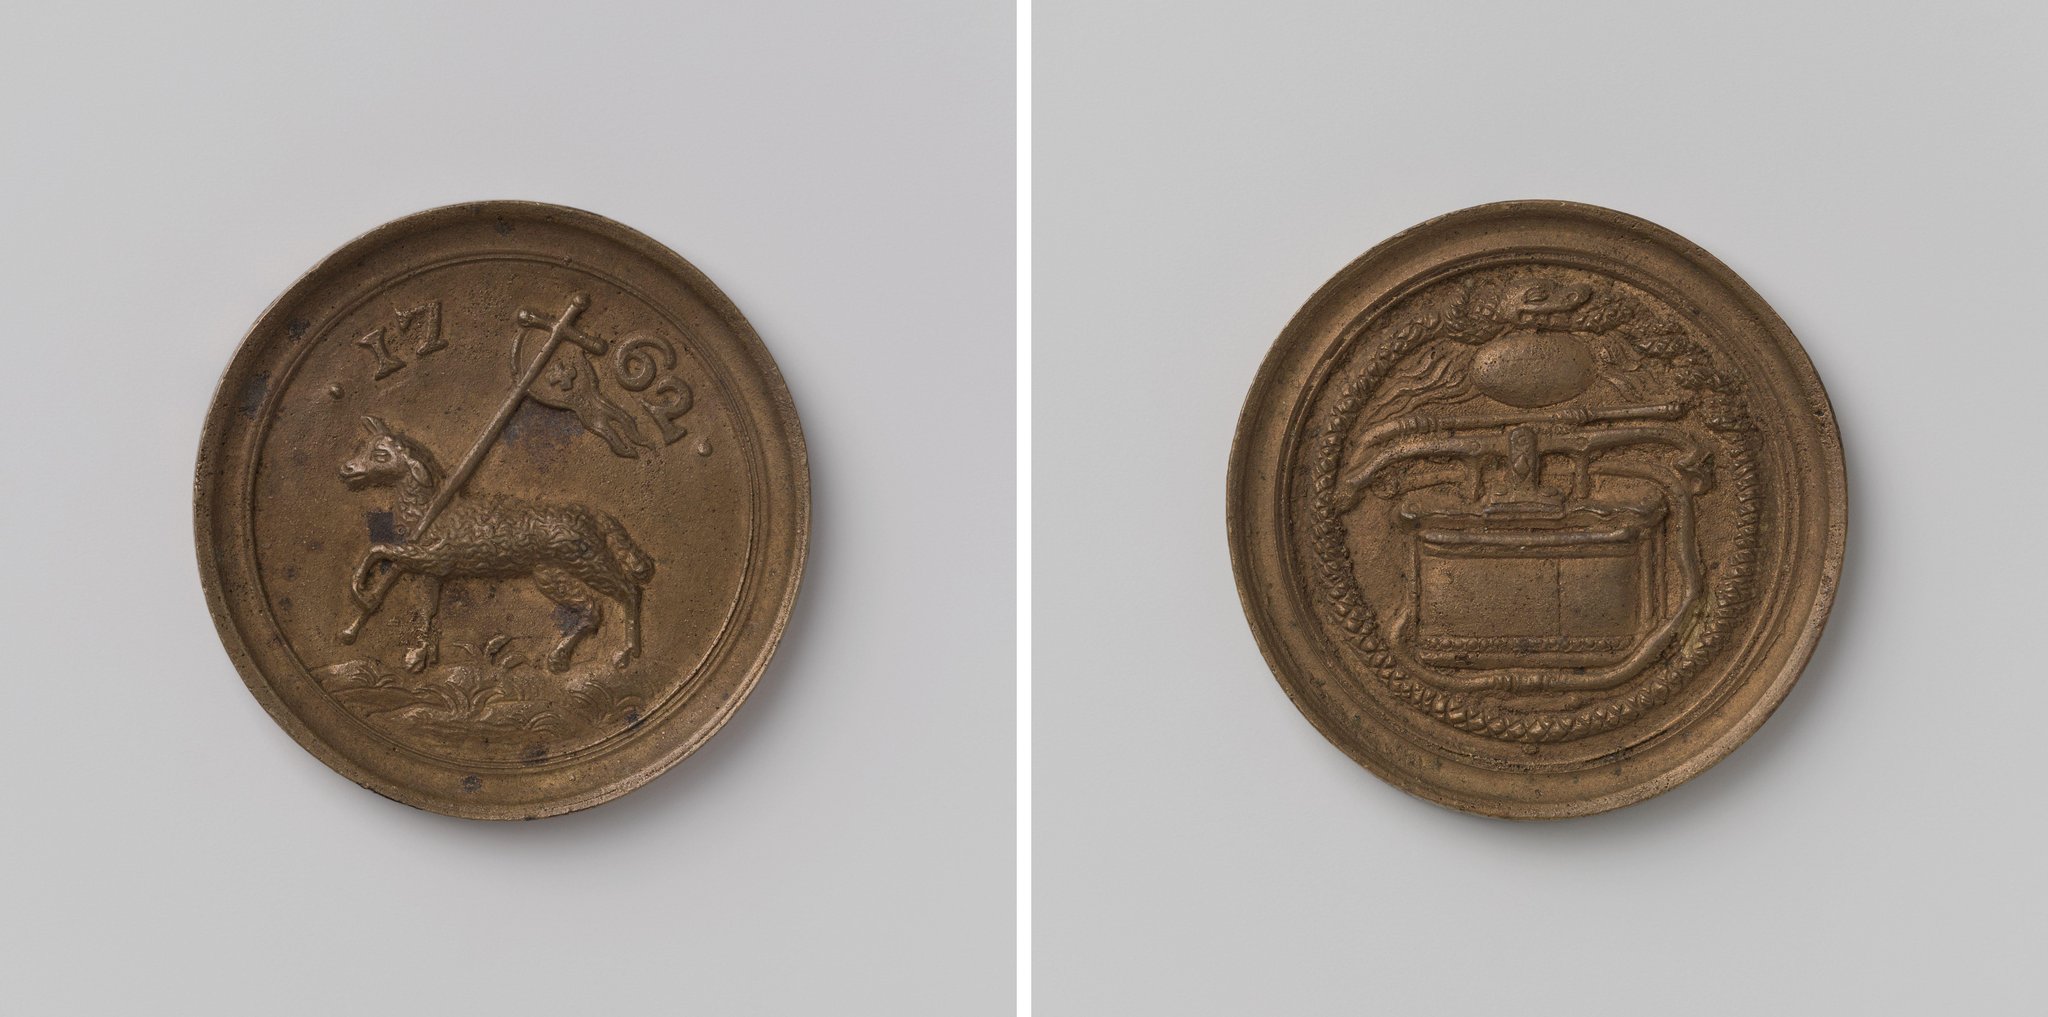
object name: fire engine medal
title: Velsen, brandspuitpenning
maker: Anonymous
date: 1762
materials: brass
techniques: casting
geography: velsen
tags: velsen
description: Messing penning. Voorzijde: lam met vaandel over schouder onder jaartal. Keerzijde: brandspuit onder leeg cartouche binnen slangerond